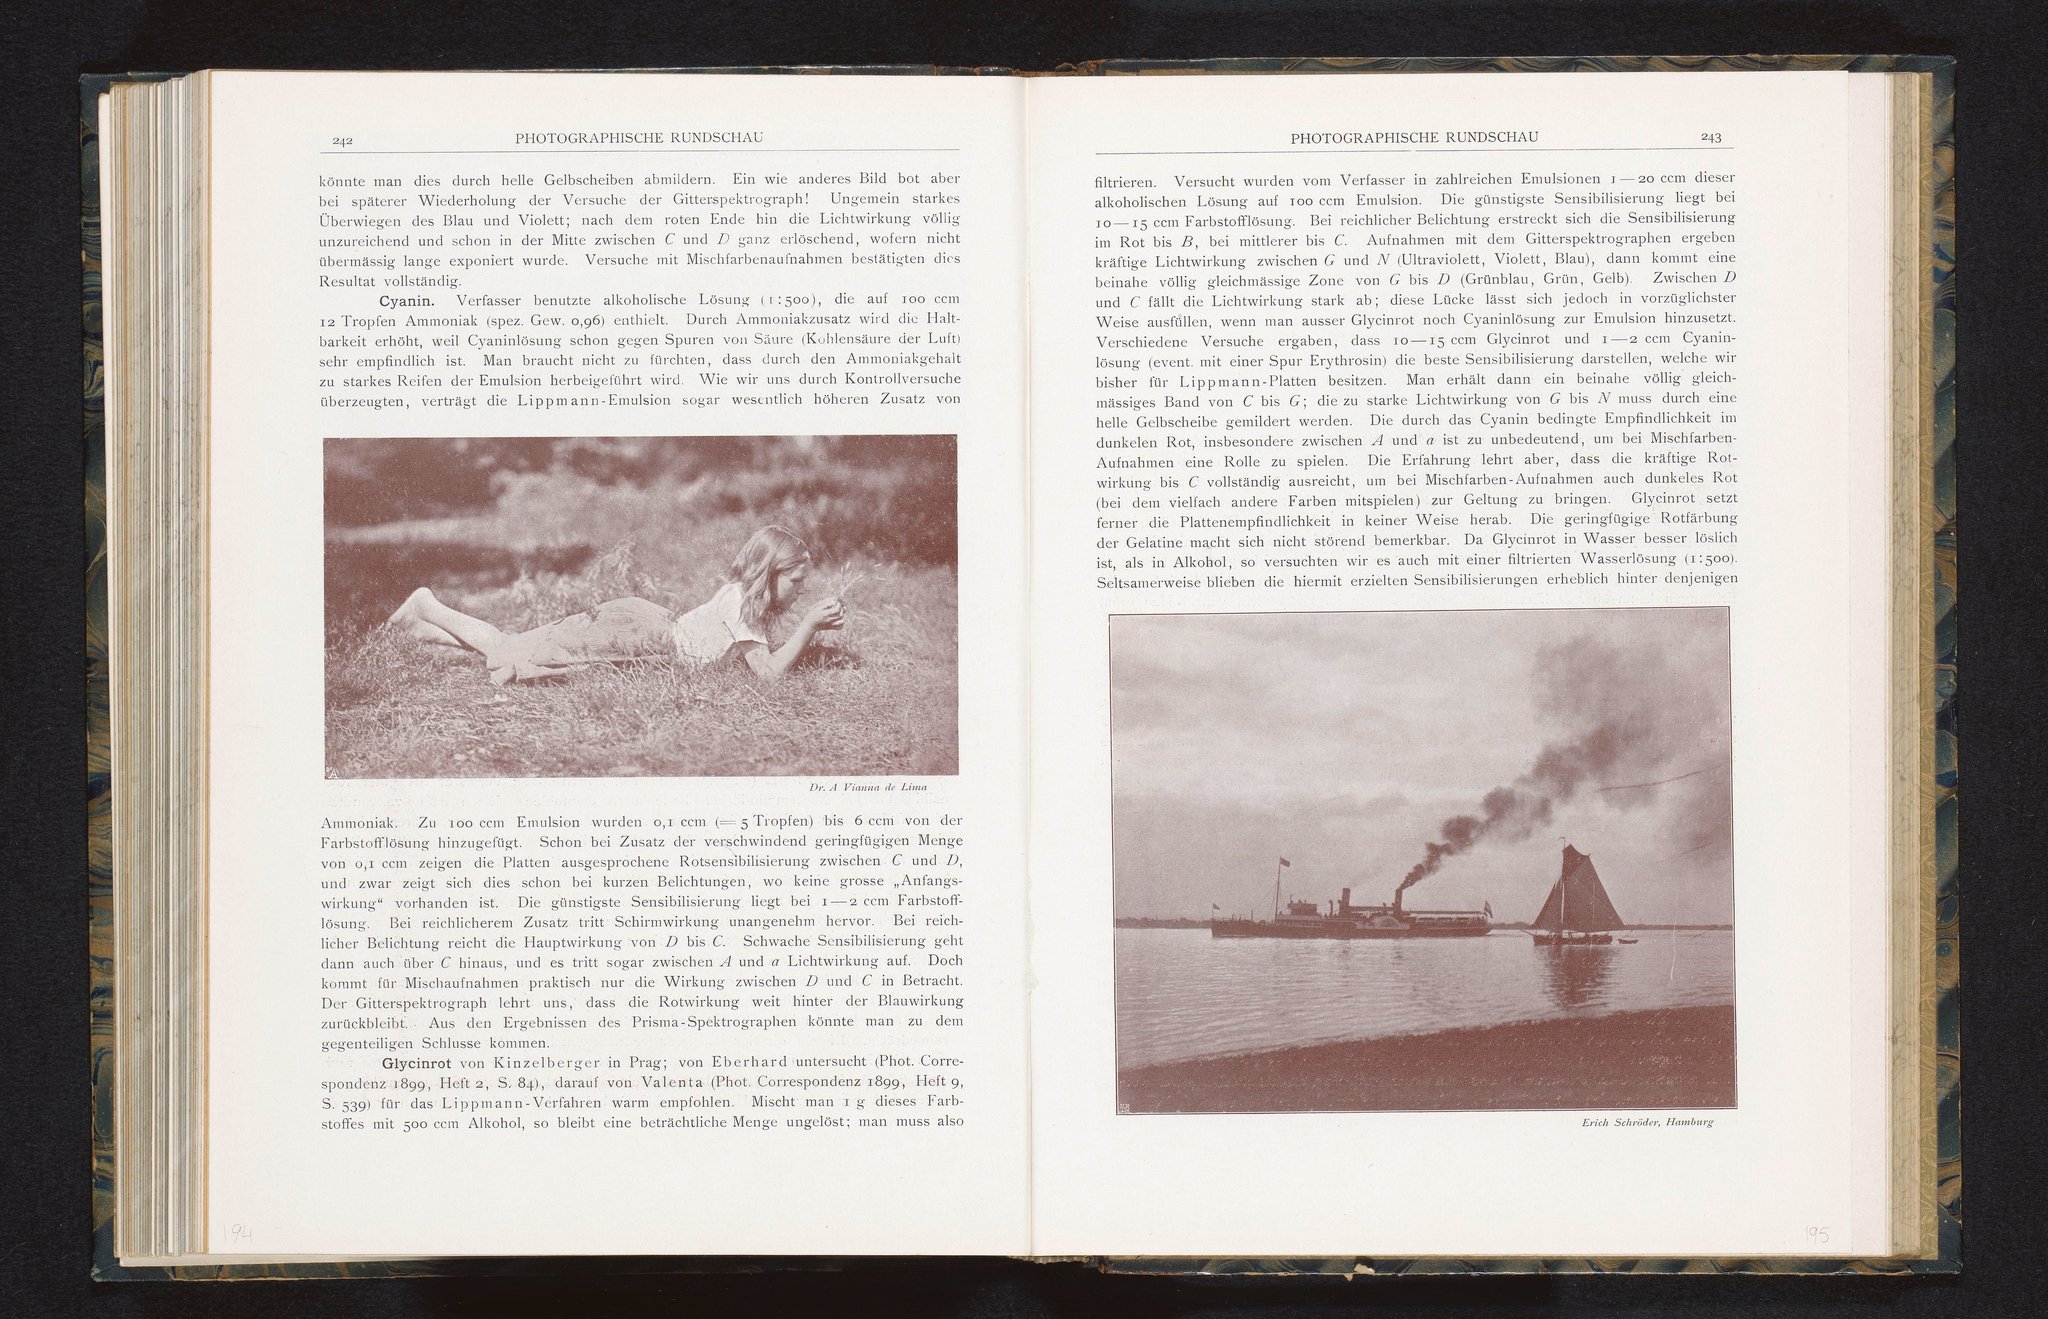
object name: photomechanical print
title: Jonge onbekende vrouw die in het gras ligt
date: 1895-1900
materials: paper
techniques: autotype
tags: adolescent, young woman, maiden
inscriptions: monogram: ‘drAco’